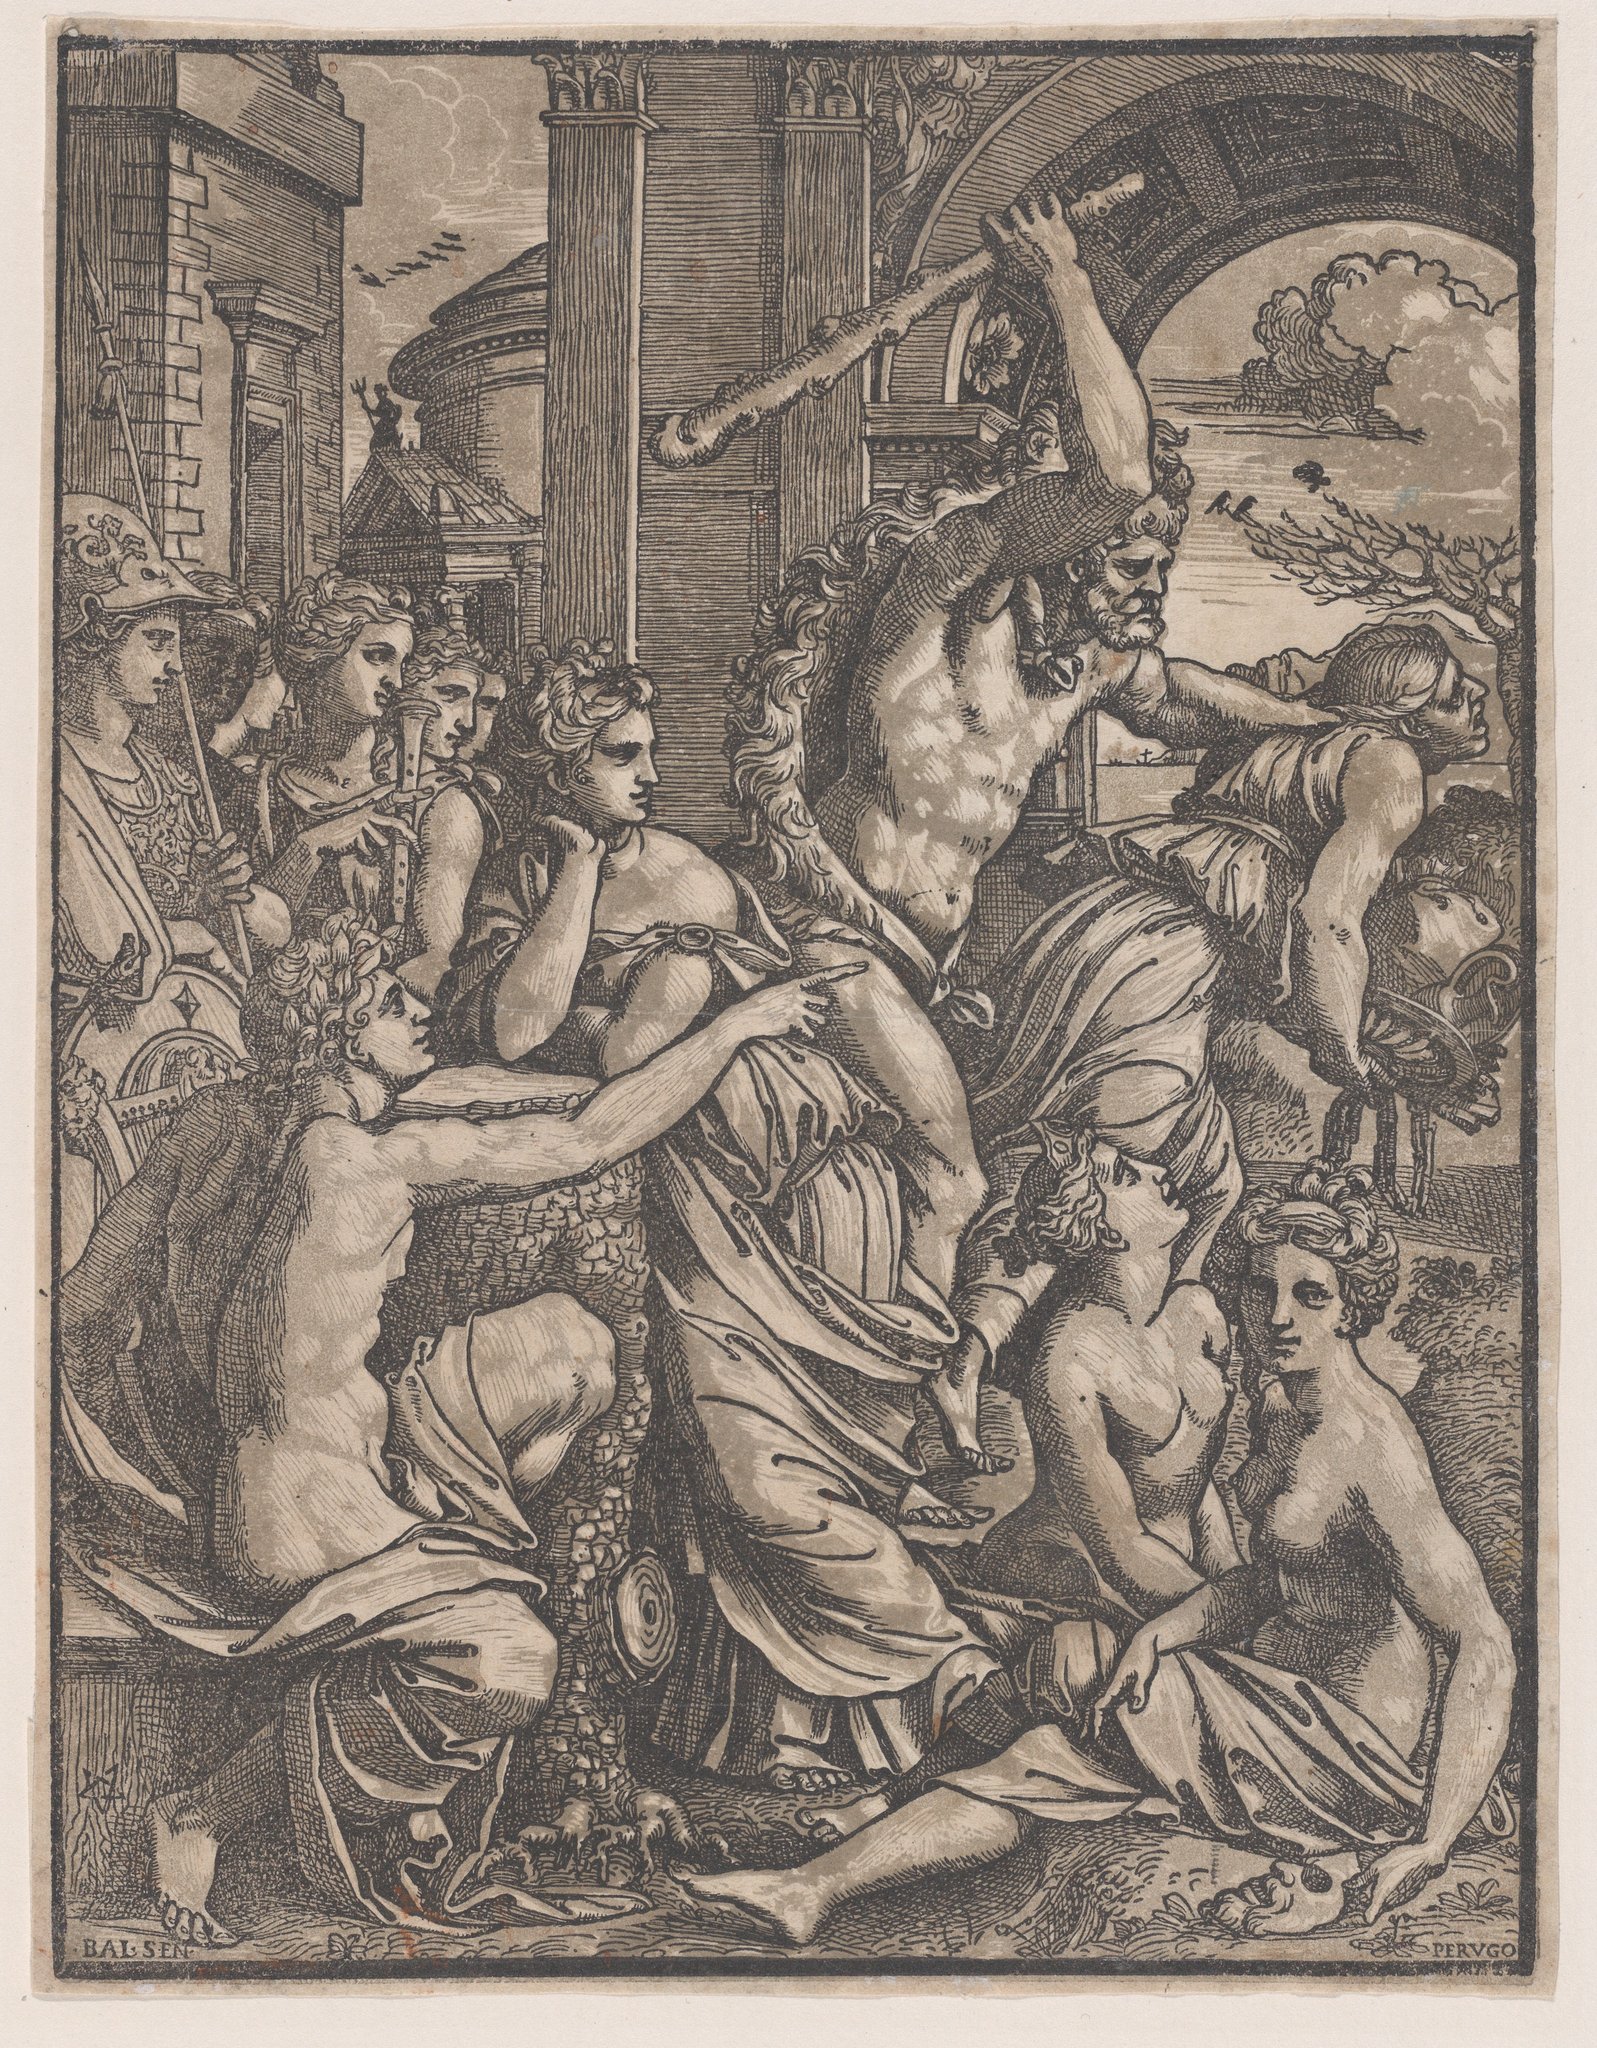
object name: print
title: Hercules chasing Avarice from the Temple of the Muses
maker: ugo da carpi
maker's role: artist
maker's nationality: italian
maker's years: 1480-1532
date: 1520-1527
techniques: woodcut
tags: mythology,men,female nudes,hercules